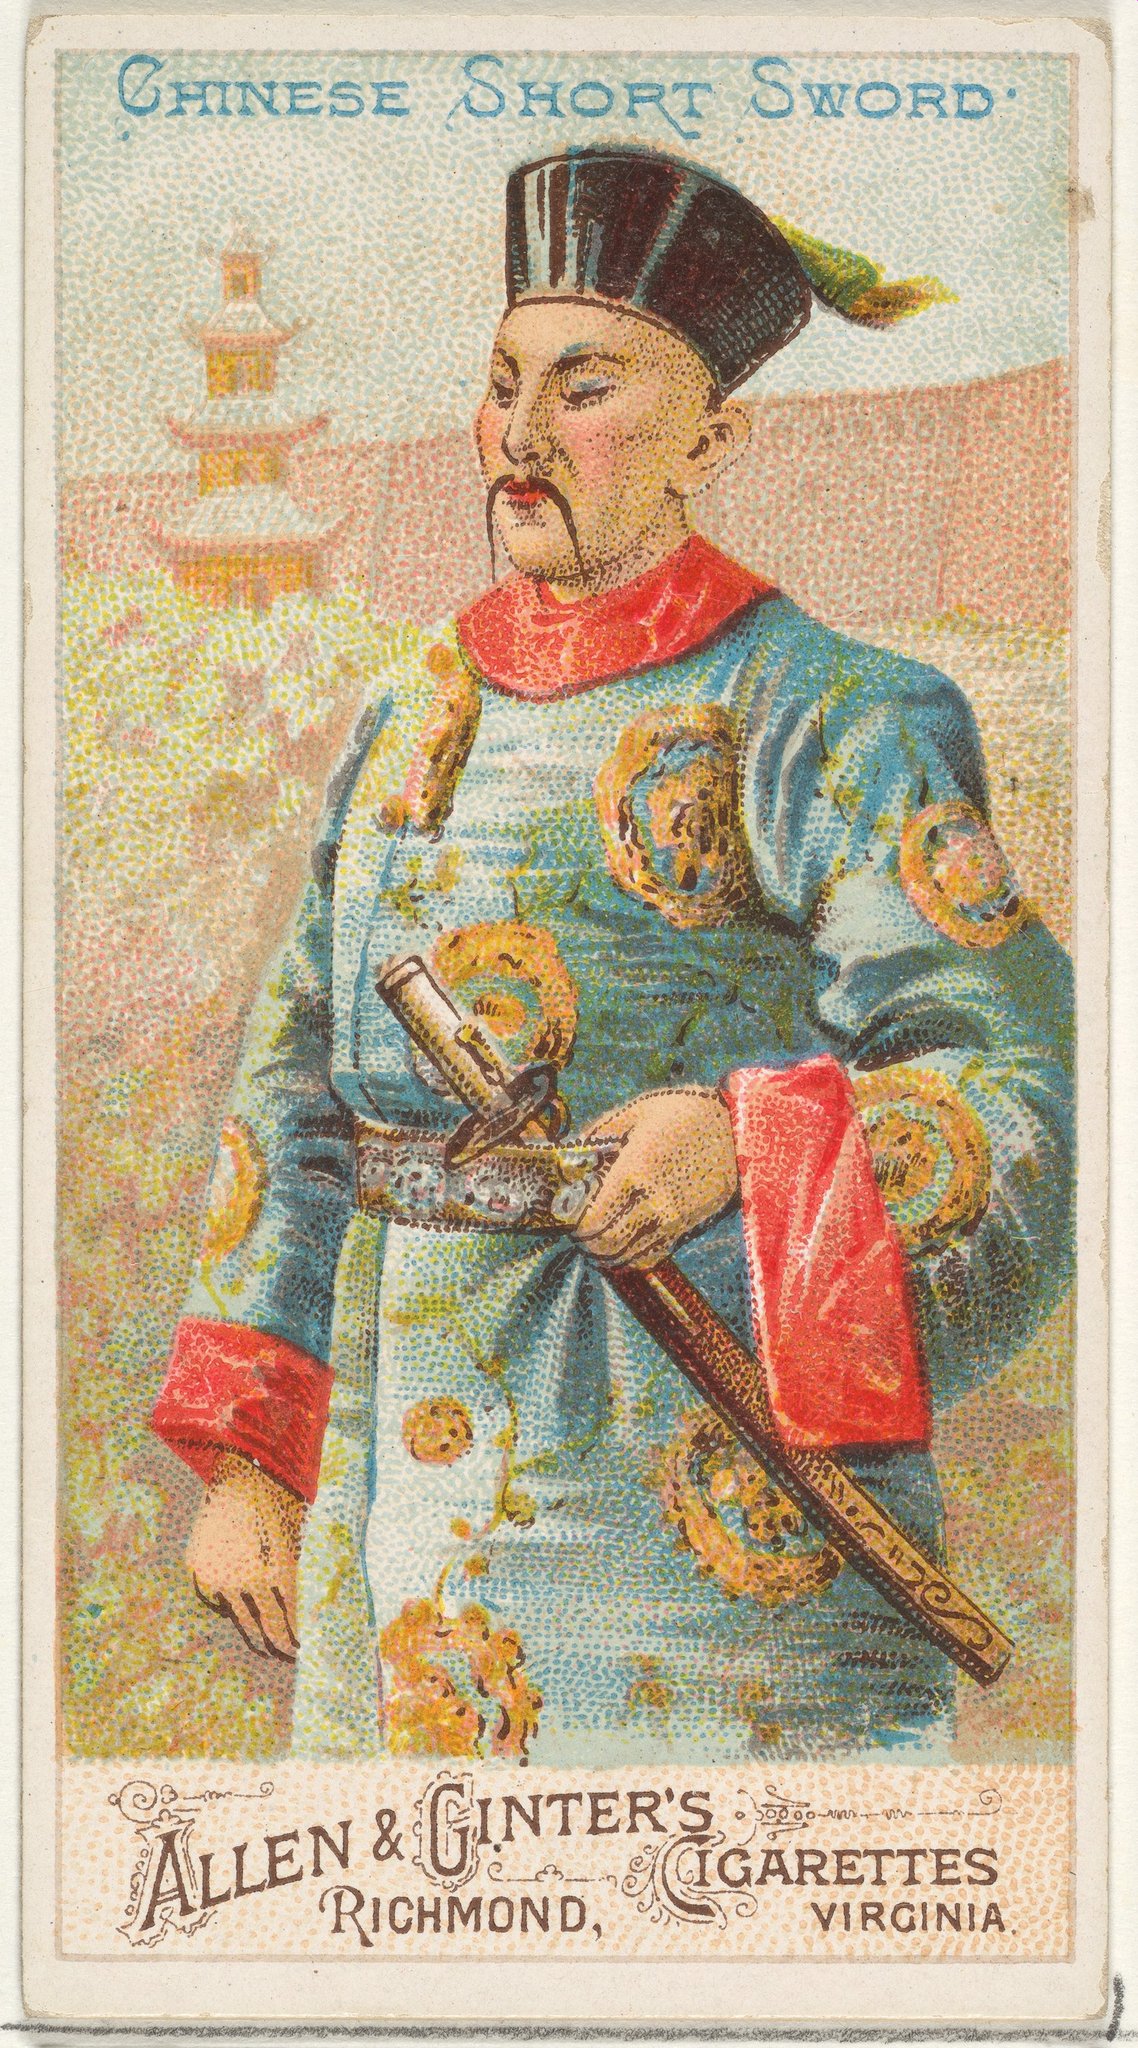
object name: print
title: Chinese Short Sword, from the Arms of All Nations series (N3) for Allen & Ginter Cigarettes Brands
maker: allen & ginter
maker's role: publisher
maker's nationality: american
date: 1887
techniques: color lithograph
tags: swords,men